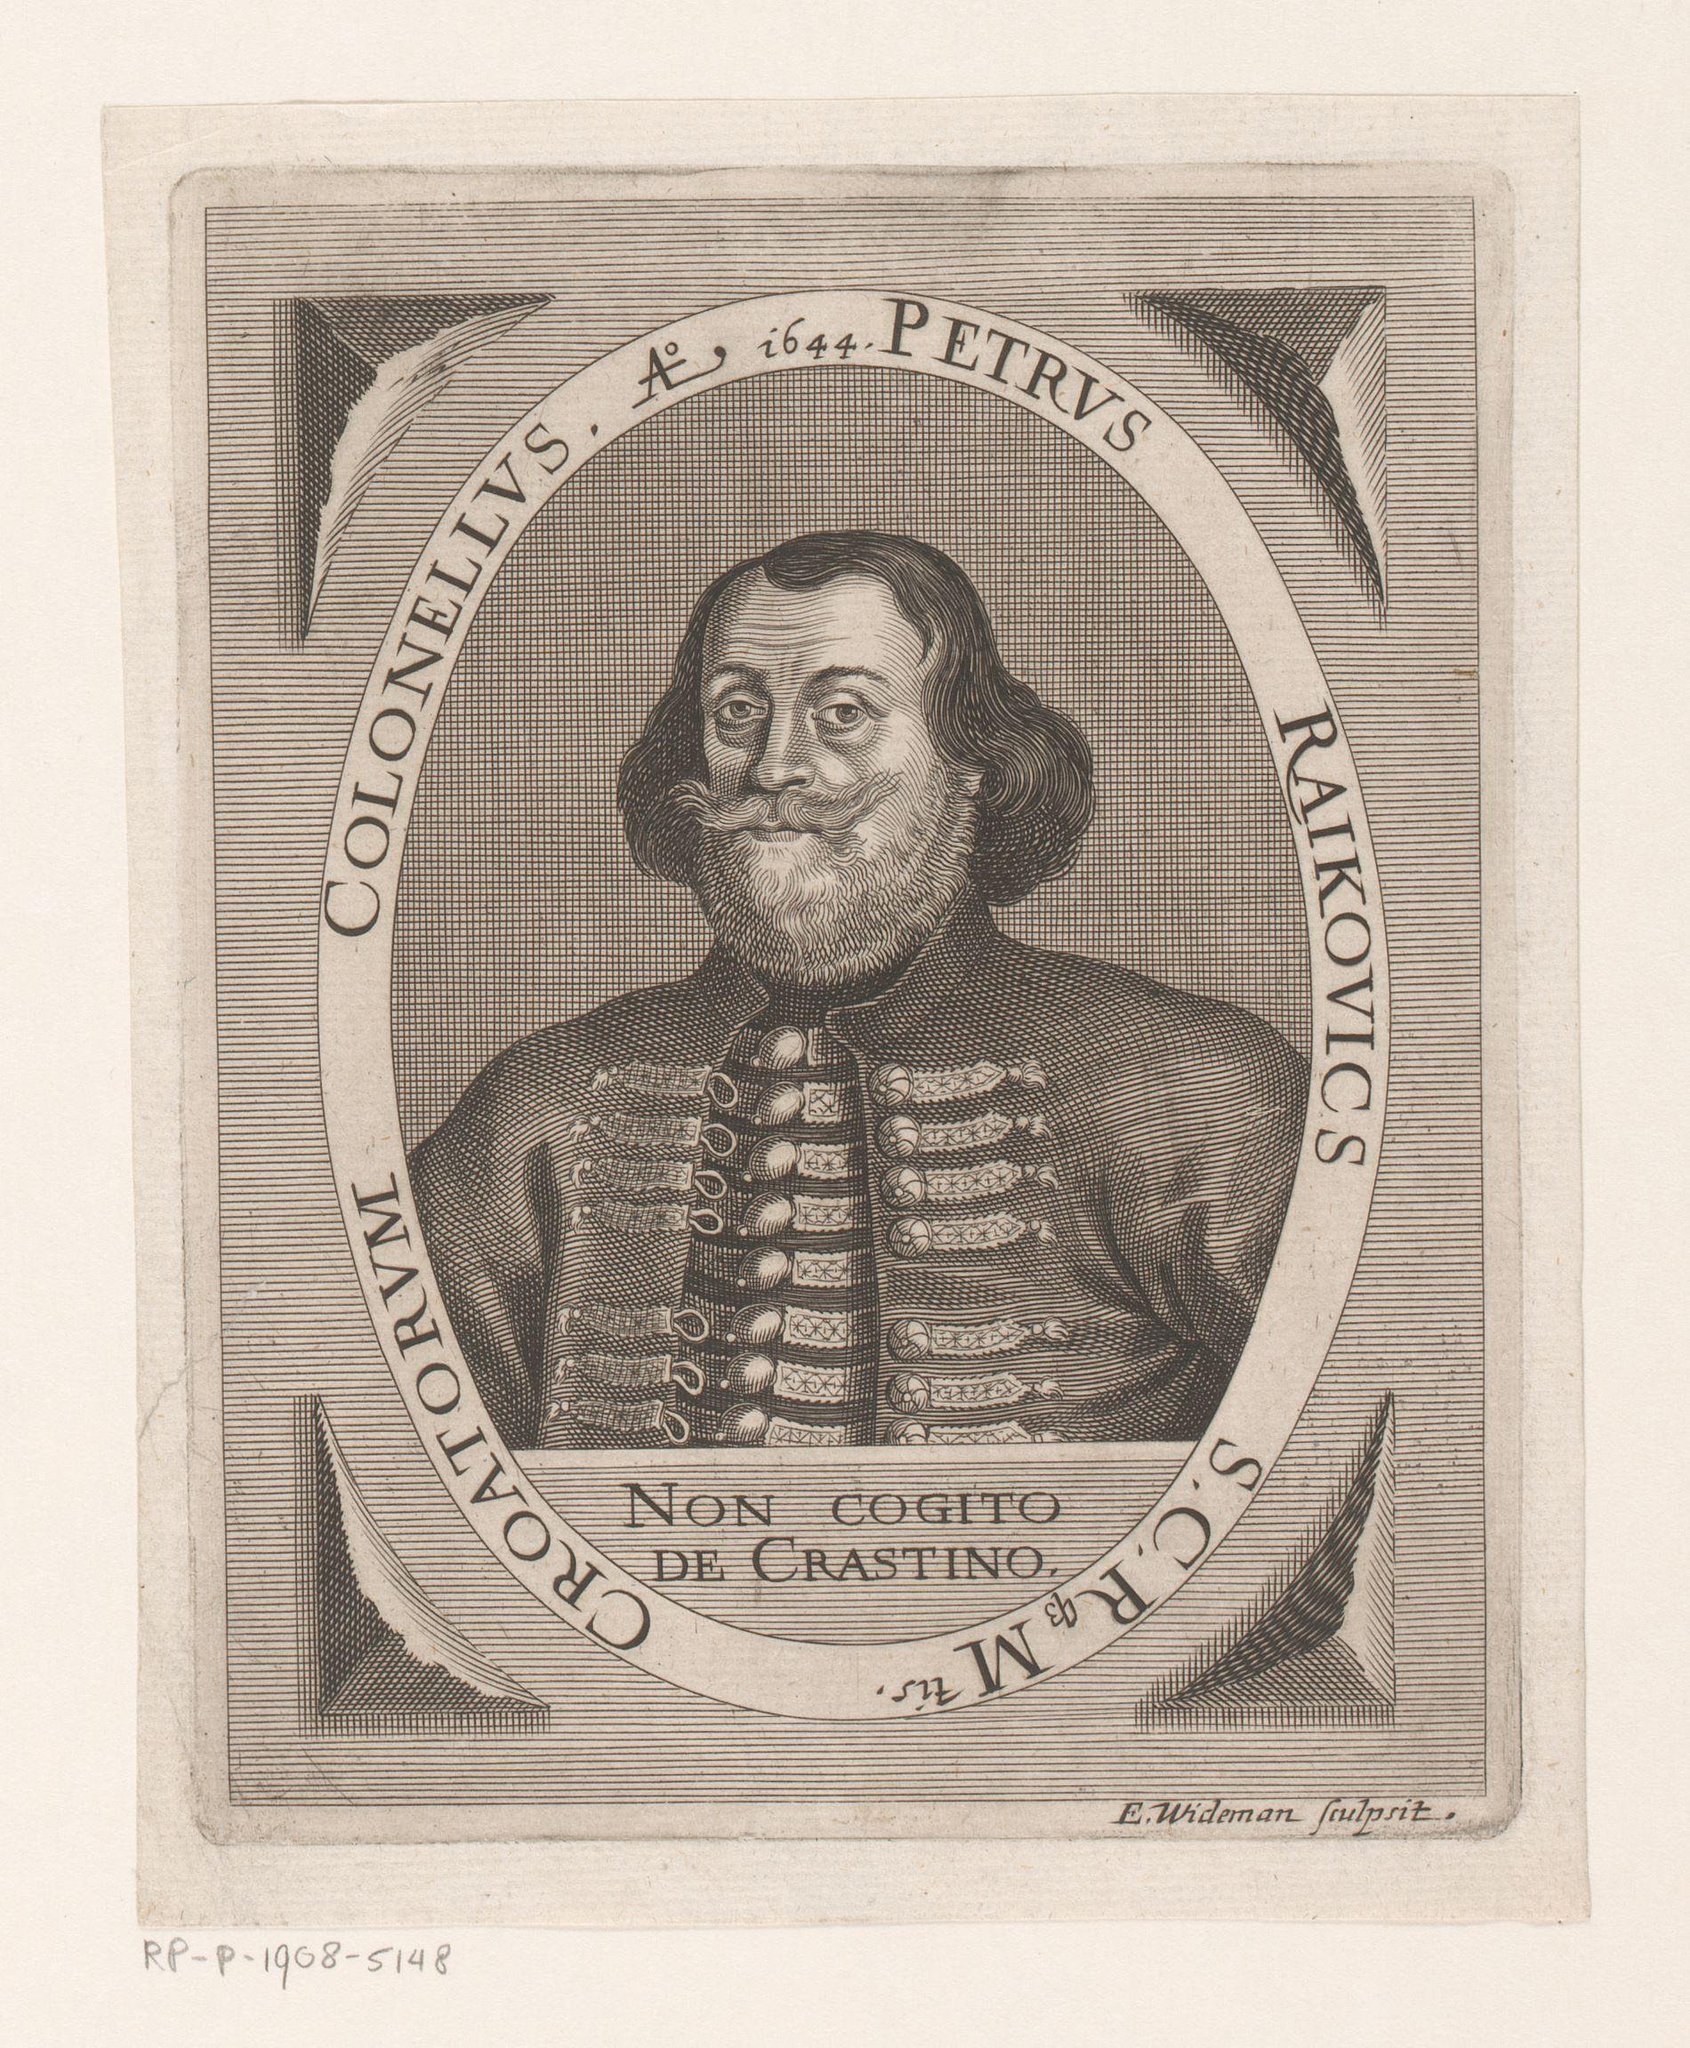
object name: print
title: Portret van Petar Rajkovič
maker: elias widemann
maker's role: print maker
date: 1644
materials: paper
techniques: engraving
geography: vienna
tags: historical persons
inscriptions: collector's mark: Lugt 2228